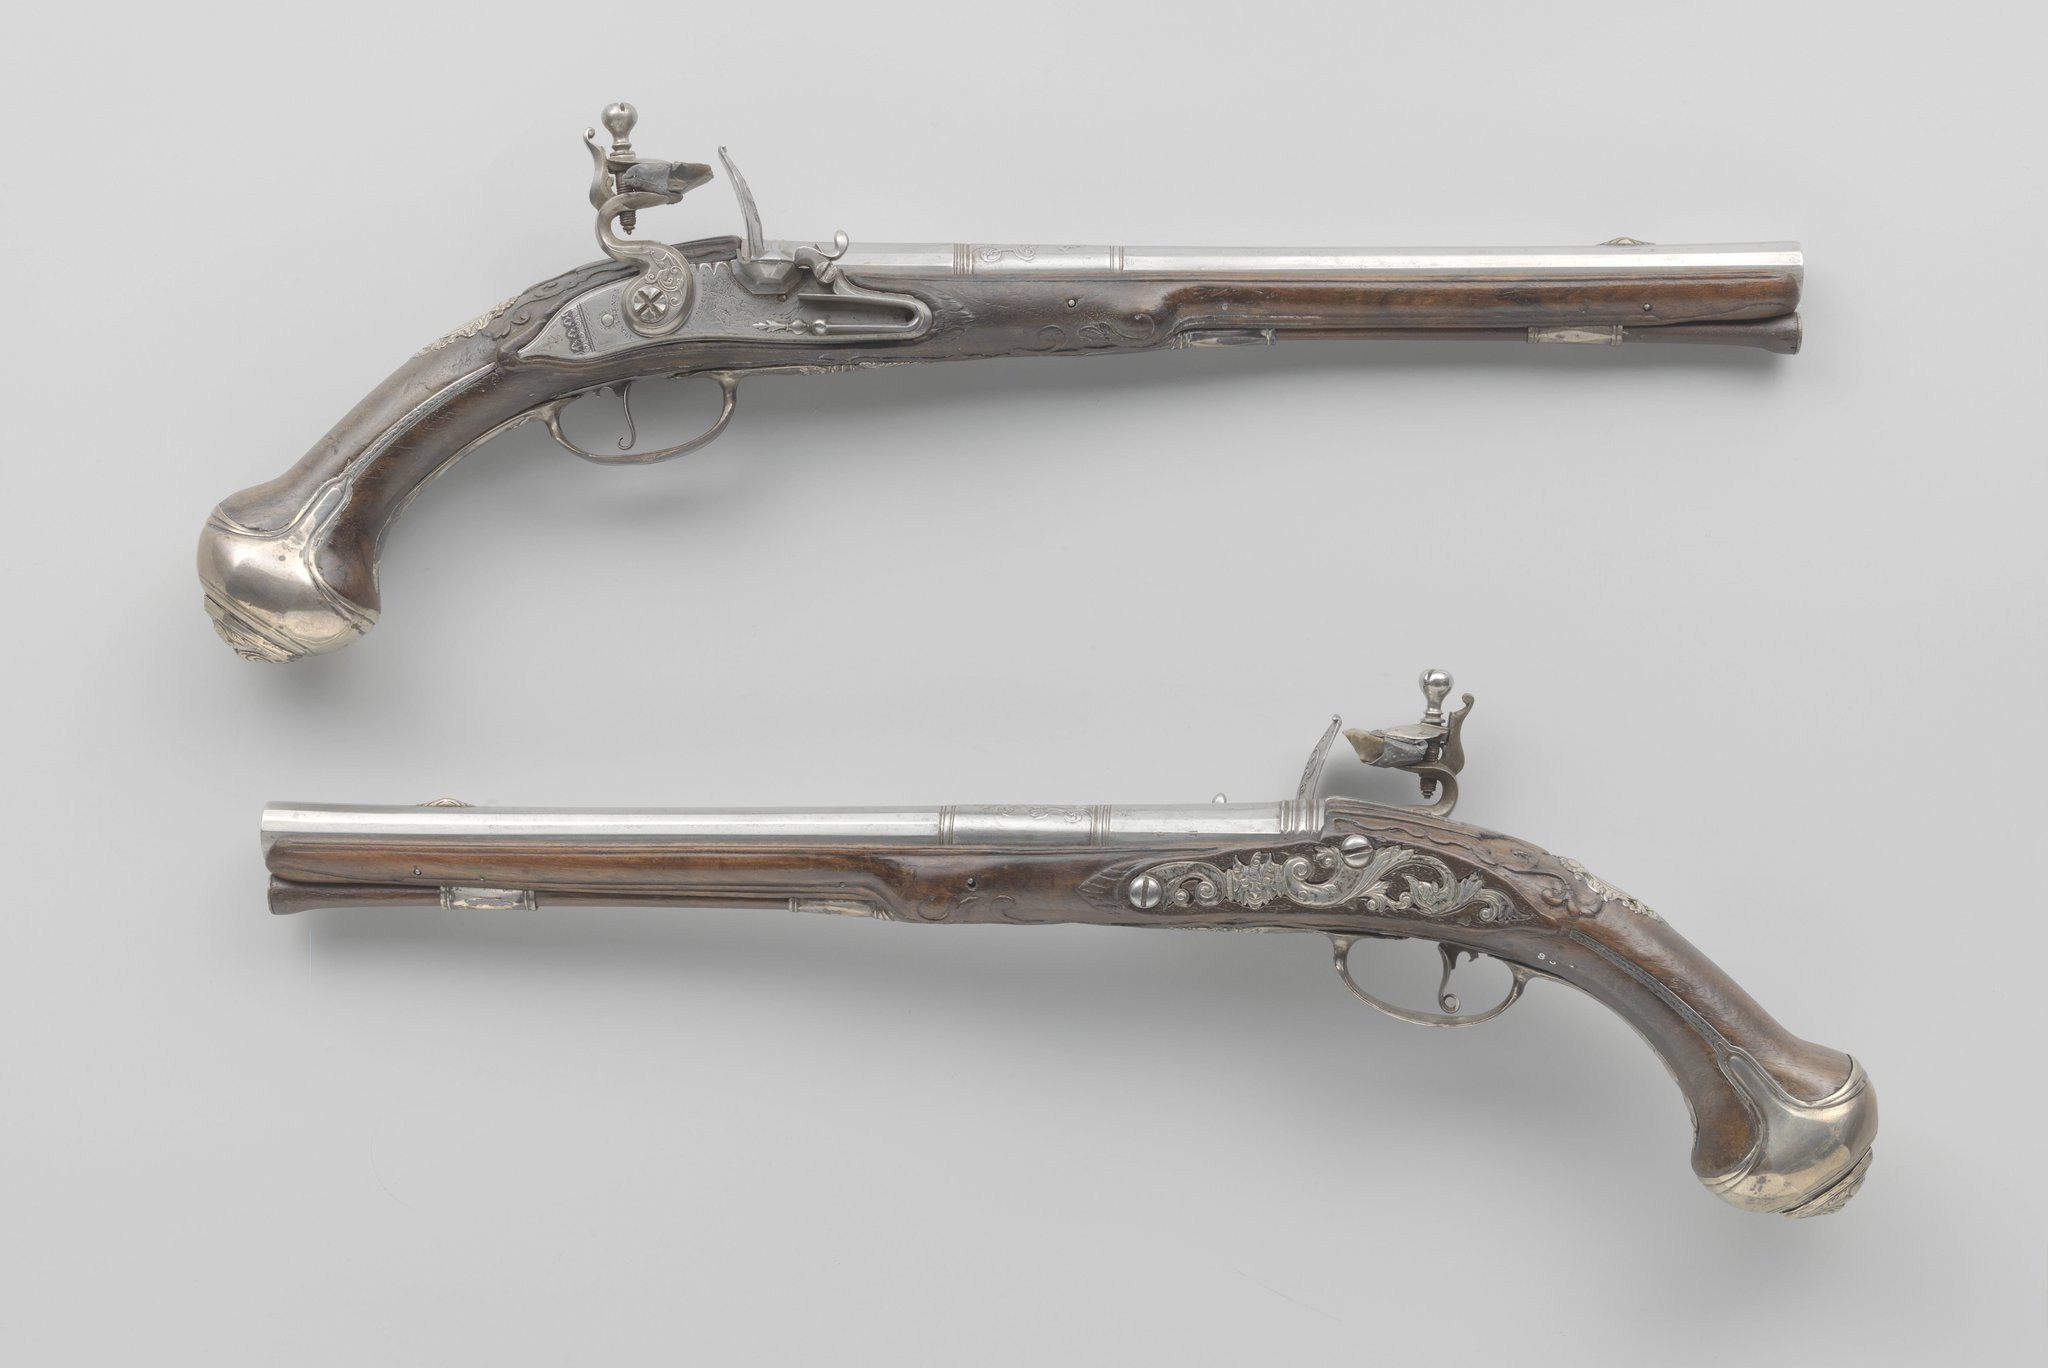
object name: flintlock pistol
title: Vuursteenpistool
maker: barend penterman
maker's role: geweermaker, pistoolmaker, vuursteenslotmaker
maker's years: -1723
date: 1703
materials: stone, iron, silver, wood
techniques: printing, casting, metalworking, cutting, engraving, grinding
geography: utrecht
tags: orde van de olifant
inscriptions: inscription: ‘PENTERMAN; UTRECHT’, mark